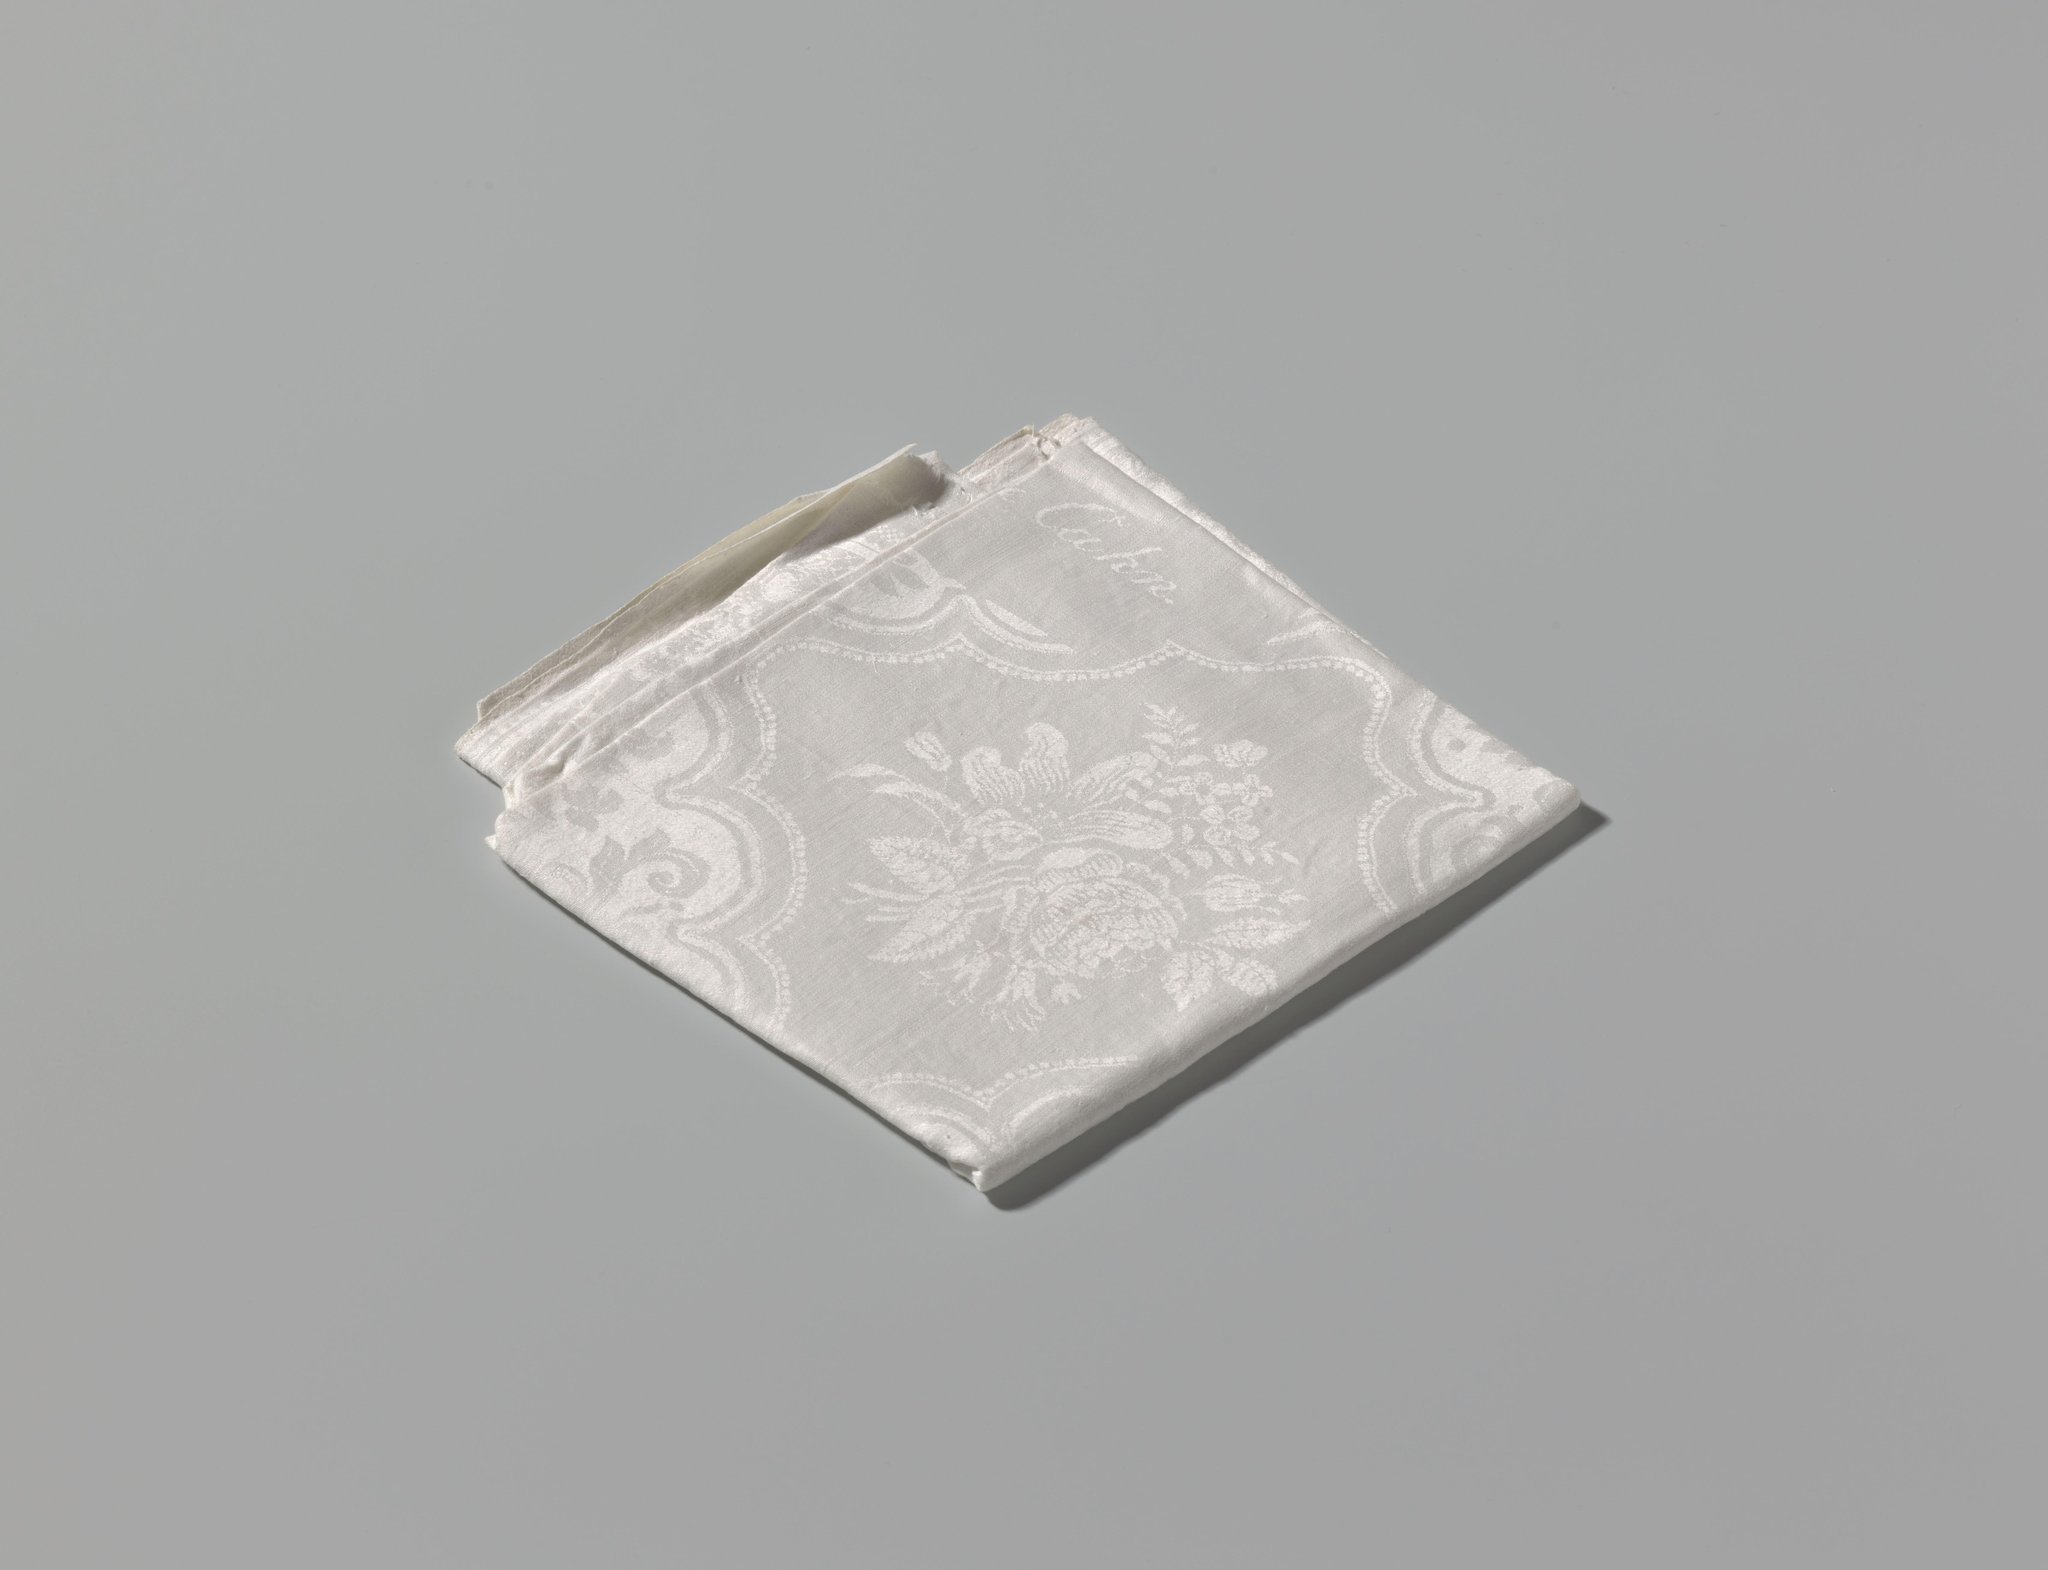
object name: napkin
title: Servet van wit linnendamast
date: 1840-1870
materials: linen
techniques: damask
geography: netherlands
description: Witlinnen damasten servet met een bloempatroon en de inweving van de namen "SIMON POLAK DANIELS" en "AMALIE CAHN".